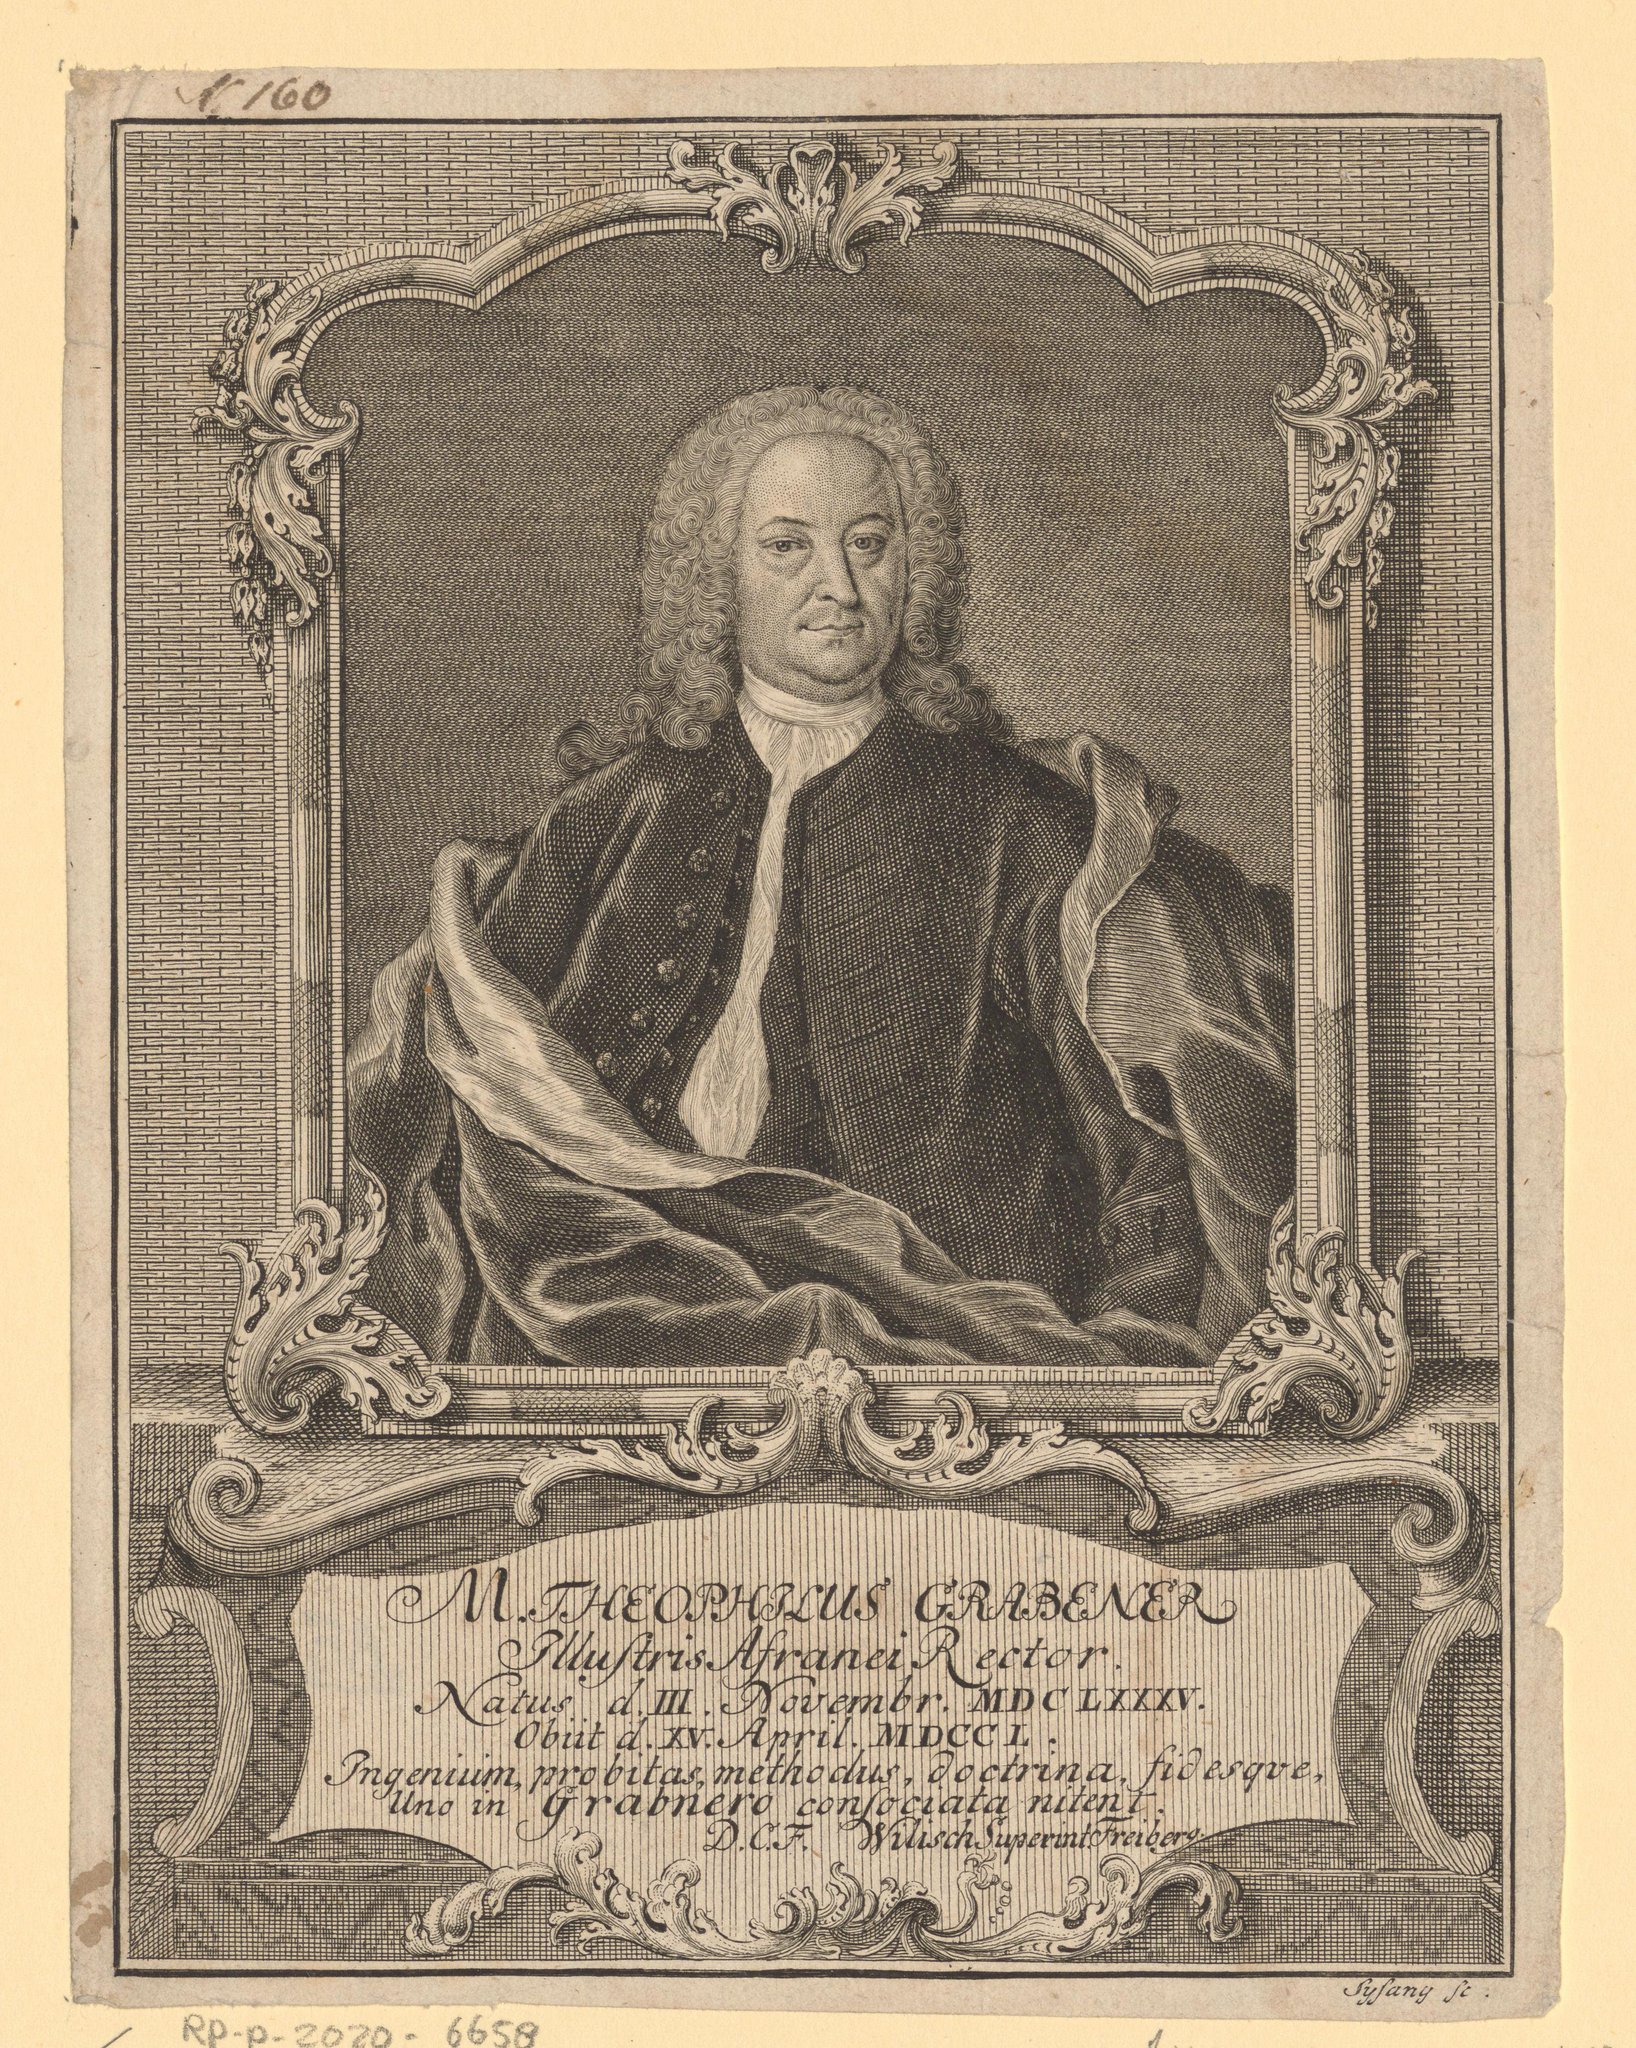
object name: print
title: Portret van Theophilus Grabener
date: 1713-1757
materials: paper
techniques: engraving, etching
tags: historical persons, professor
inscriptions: collector's mark: Lugt 358